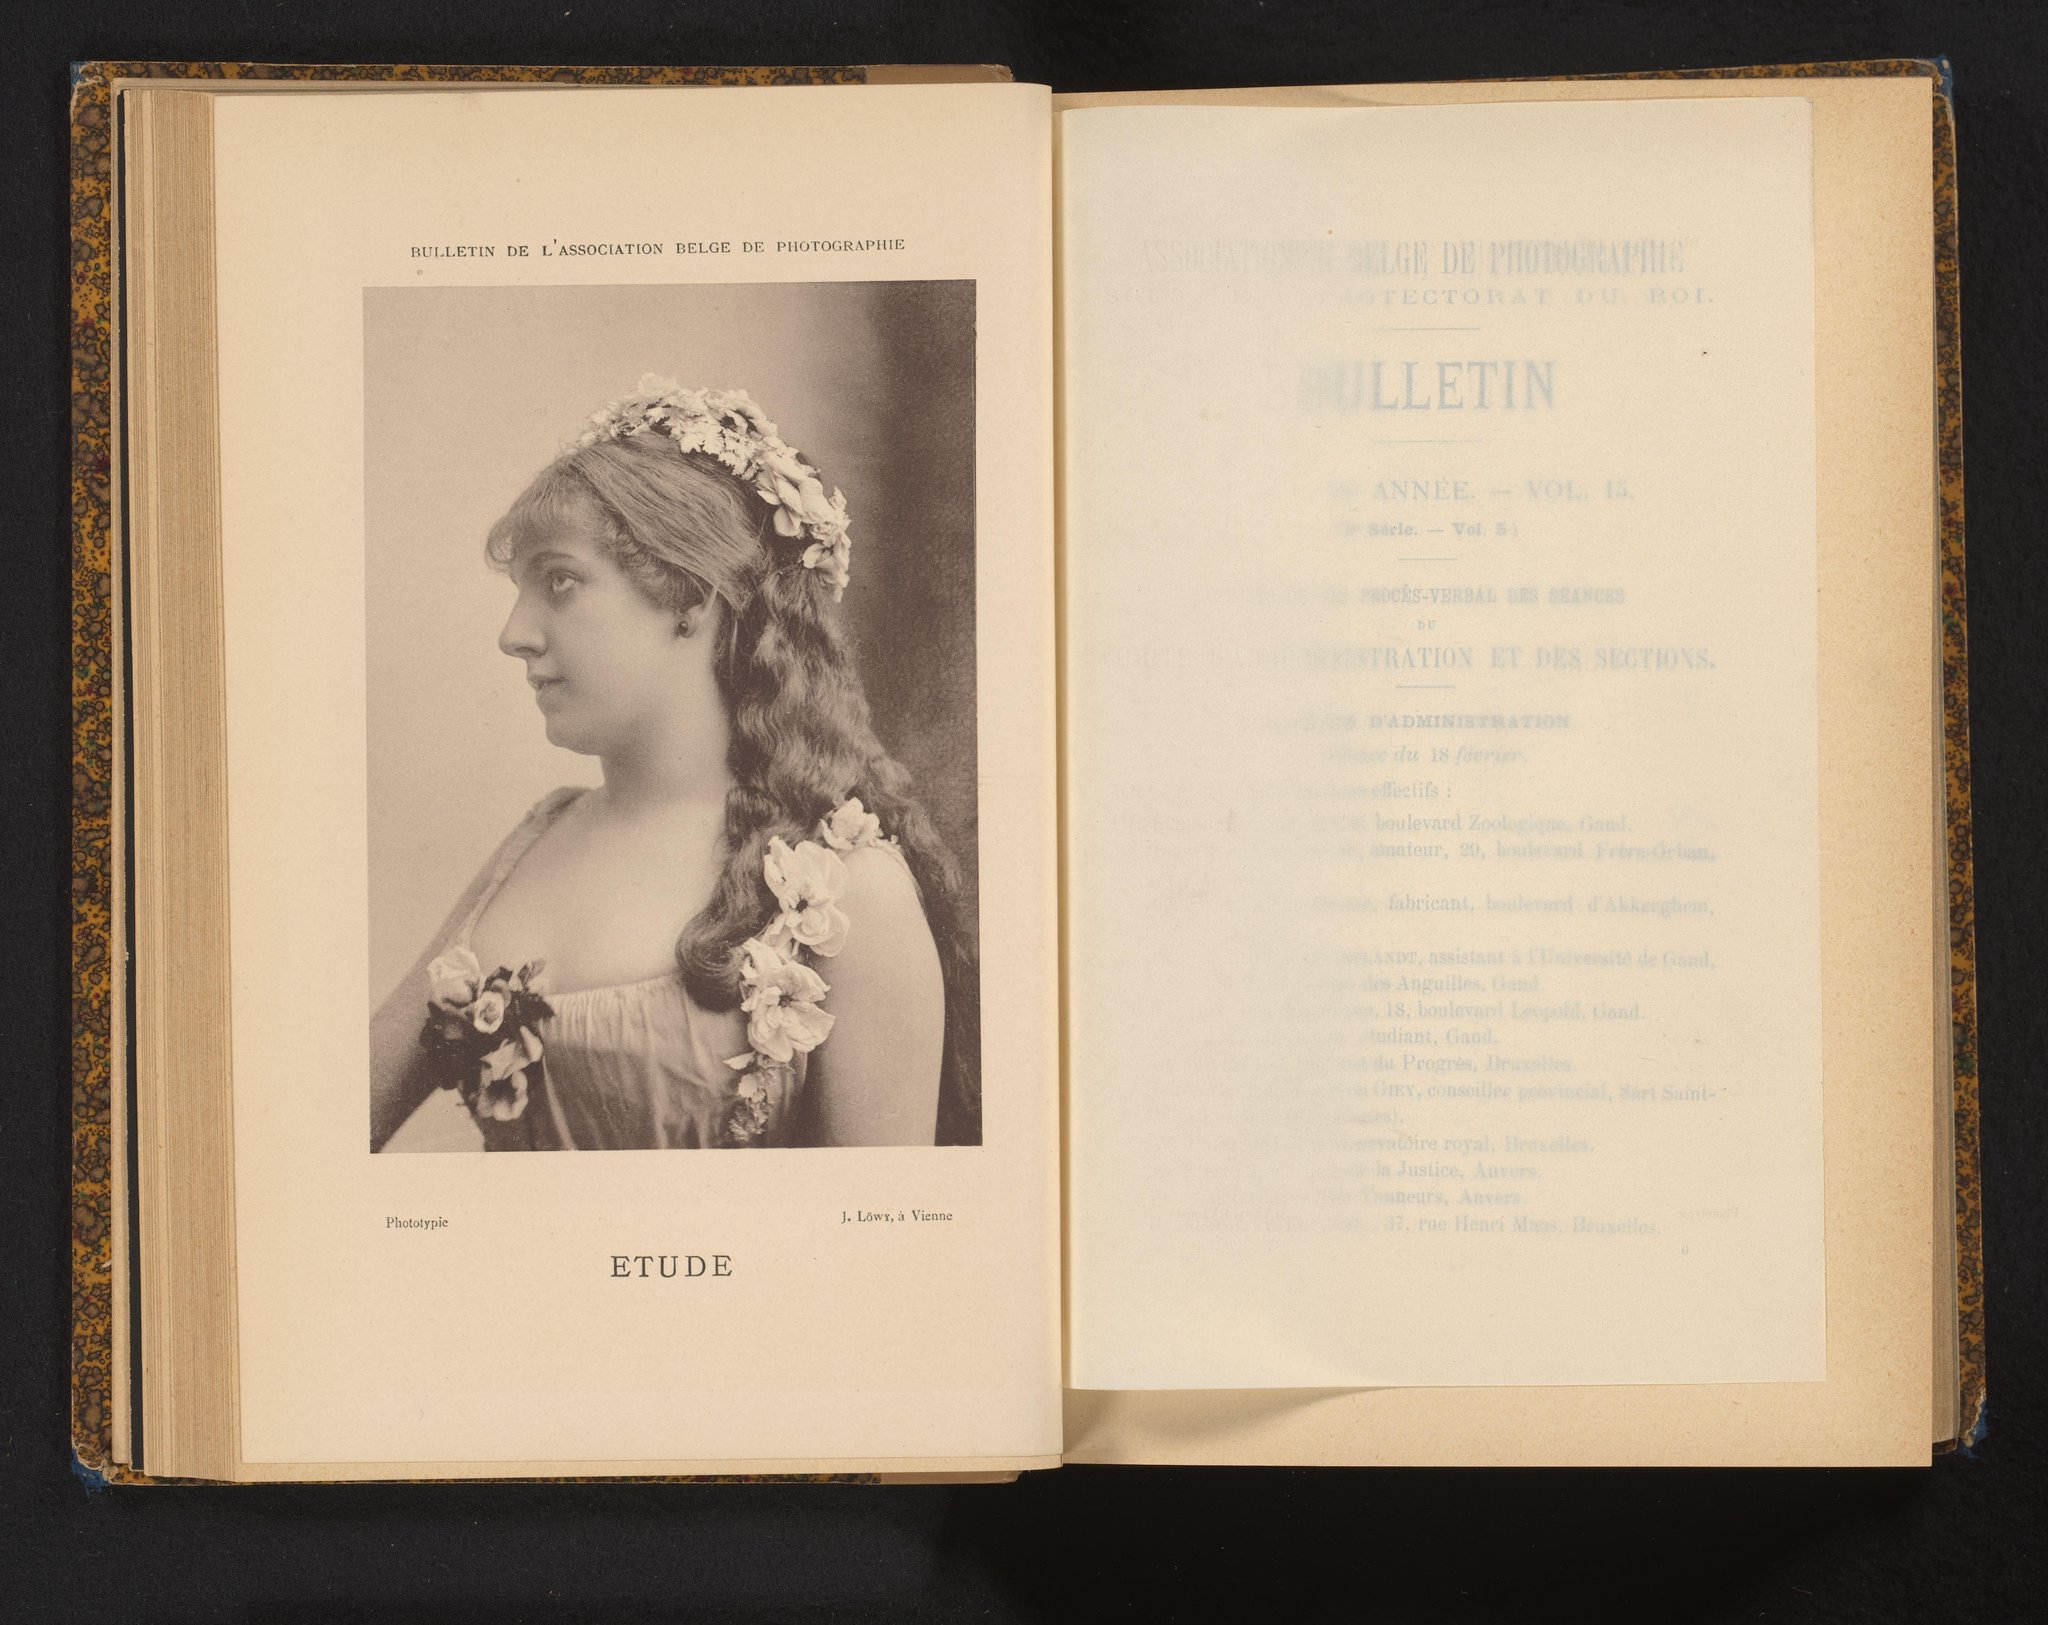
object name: photomechanical print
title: Etude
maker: josef löwy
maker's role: publisher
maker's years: 1835-1902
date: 1883-1888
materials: paper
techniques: photograph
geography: vienna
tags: flowers, adult woman, historical persons not known by name - bb - woman